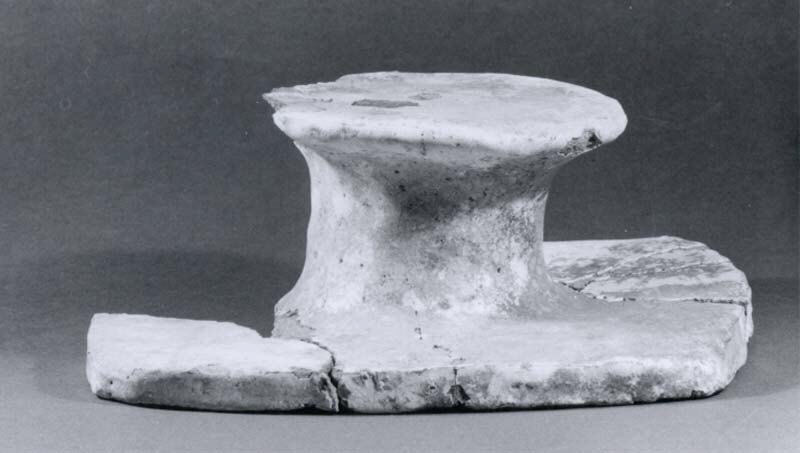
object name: wall plaque with knob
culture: iranian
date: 900-801 BCE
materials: ceramic, glaze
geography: iran